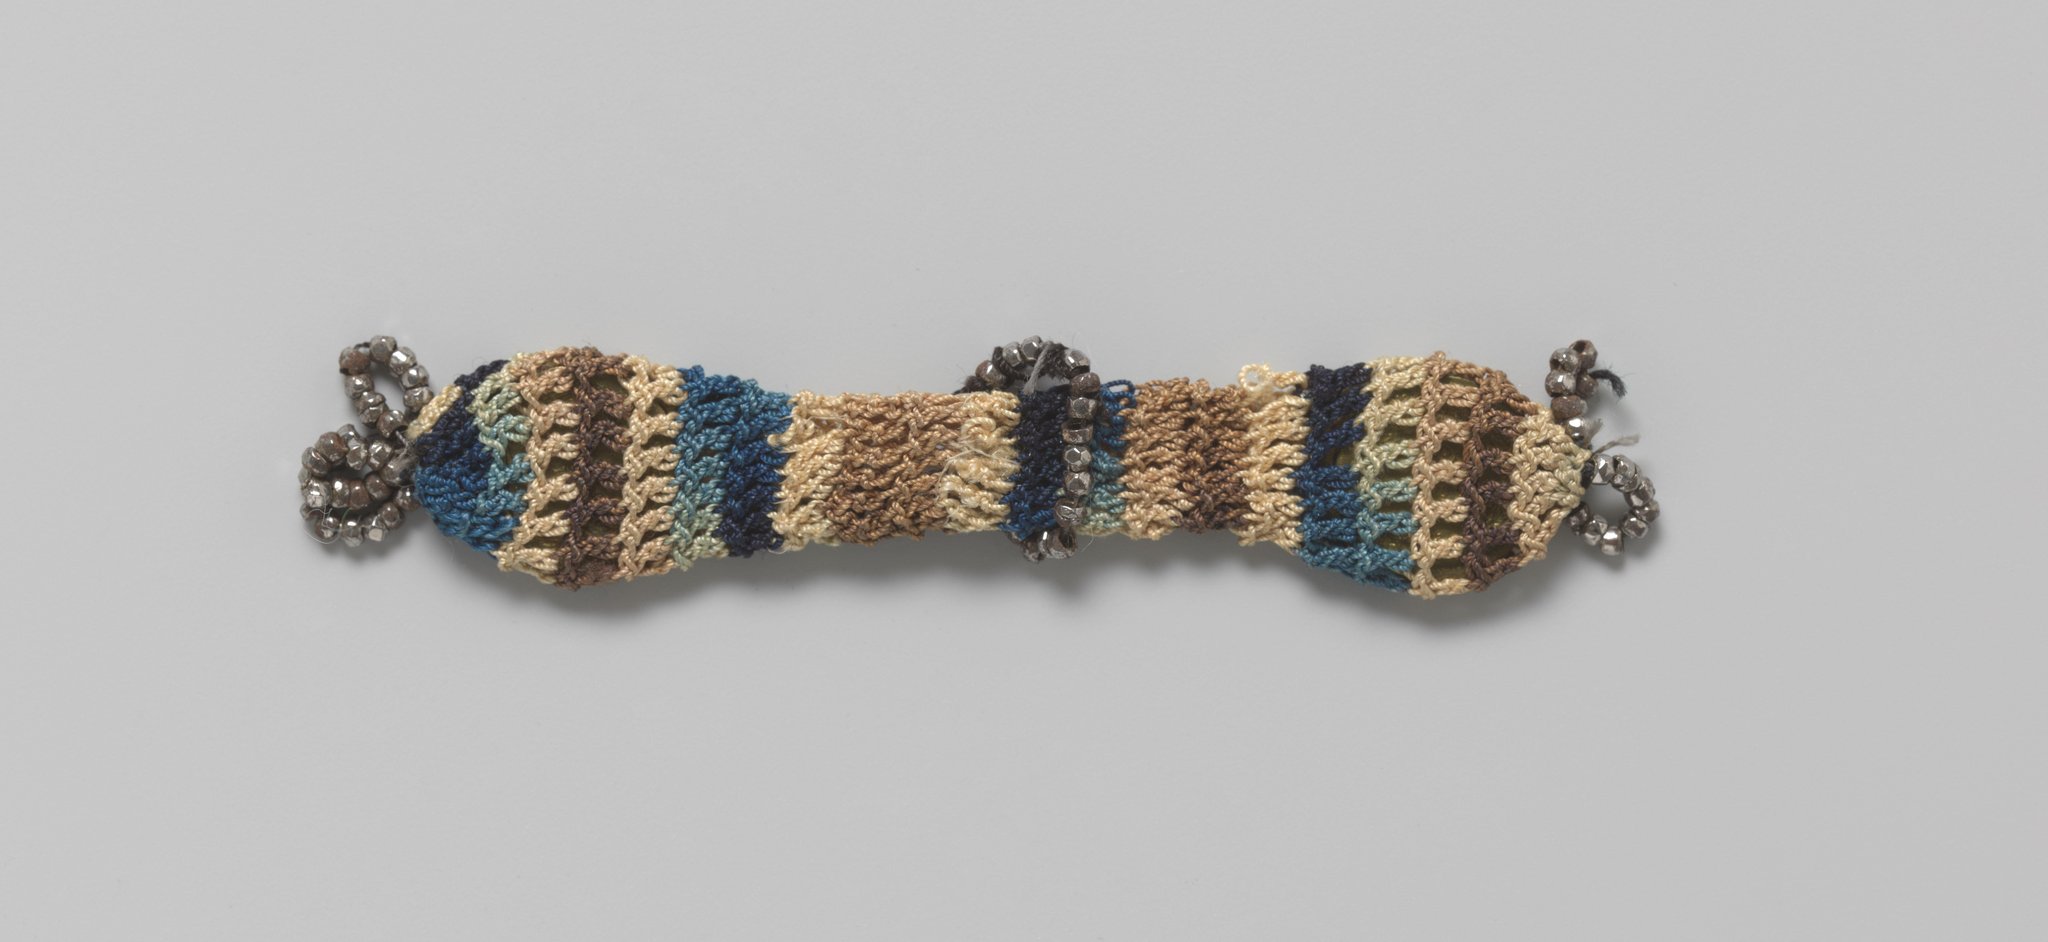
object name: poppengoed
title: Beurs, crème, blauw en bruin gestreept, gehaakt, met 4 speelmarken (spielmarken)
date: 1880-1890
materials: cotton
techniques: crochet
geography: netherlands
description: Beurs, crème, blauw en bruin gestreept, gehaakt. Met 4 speelmarken (spielmarken). Muntlek.